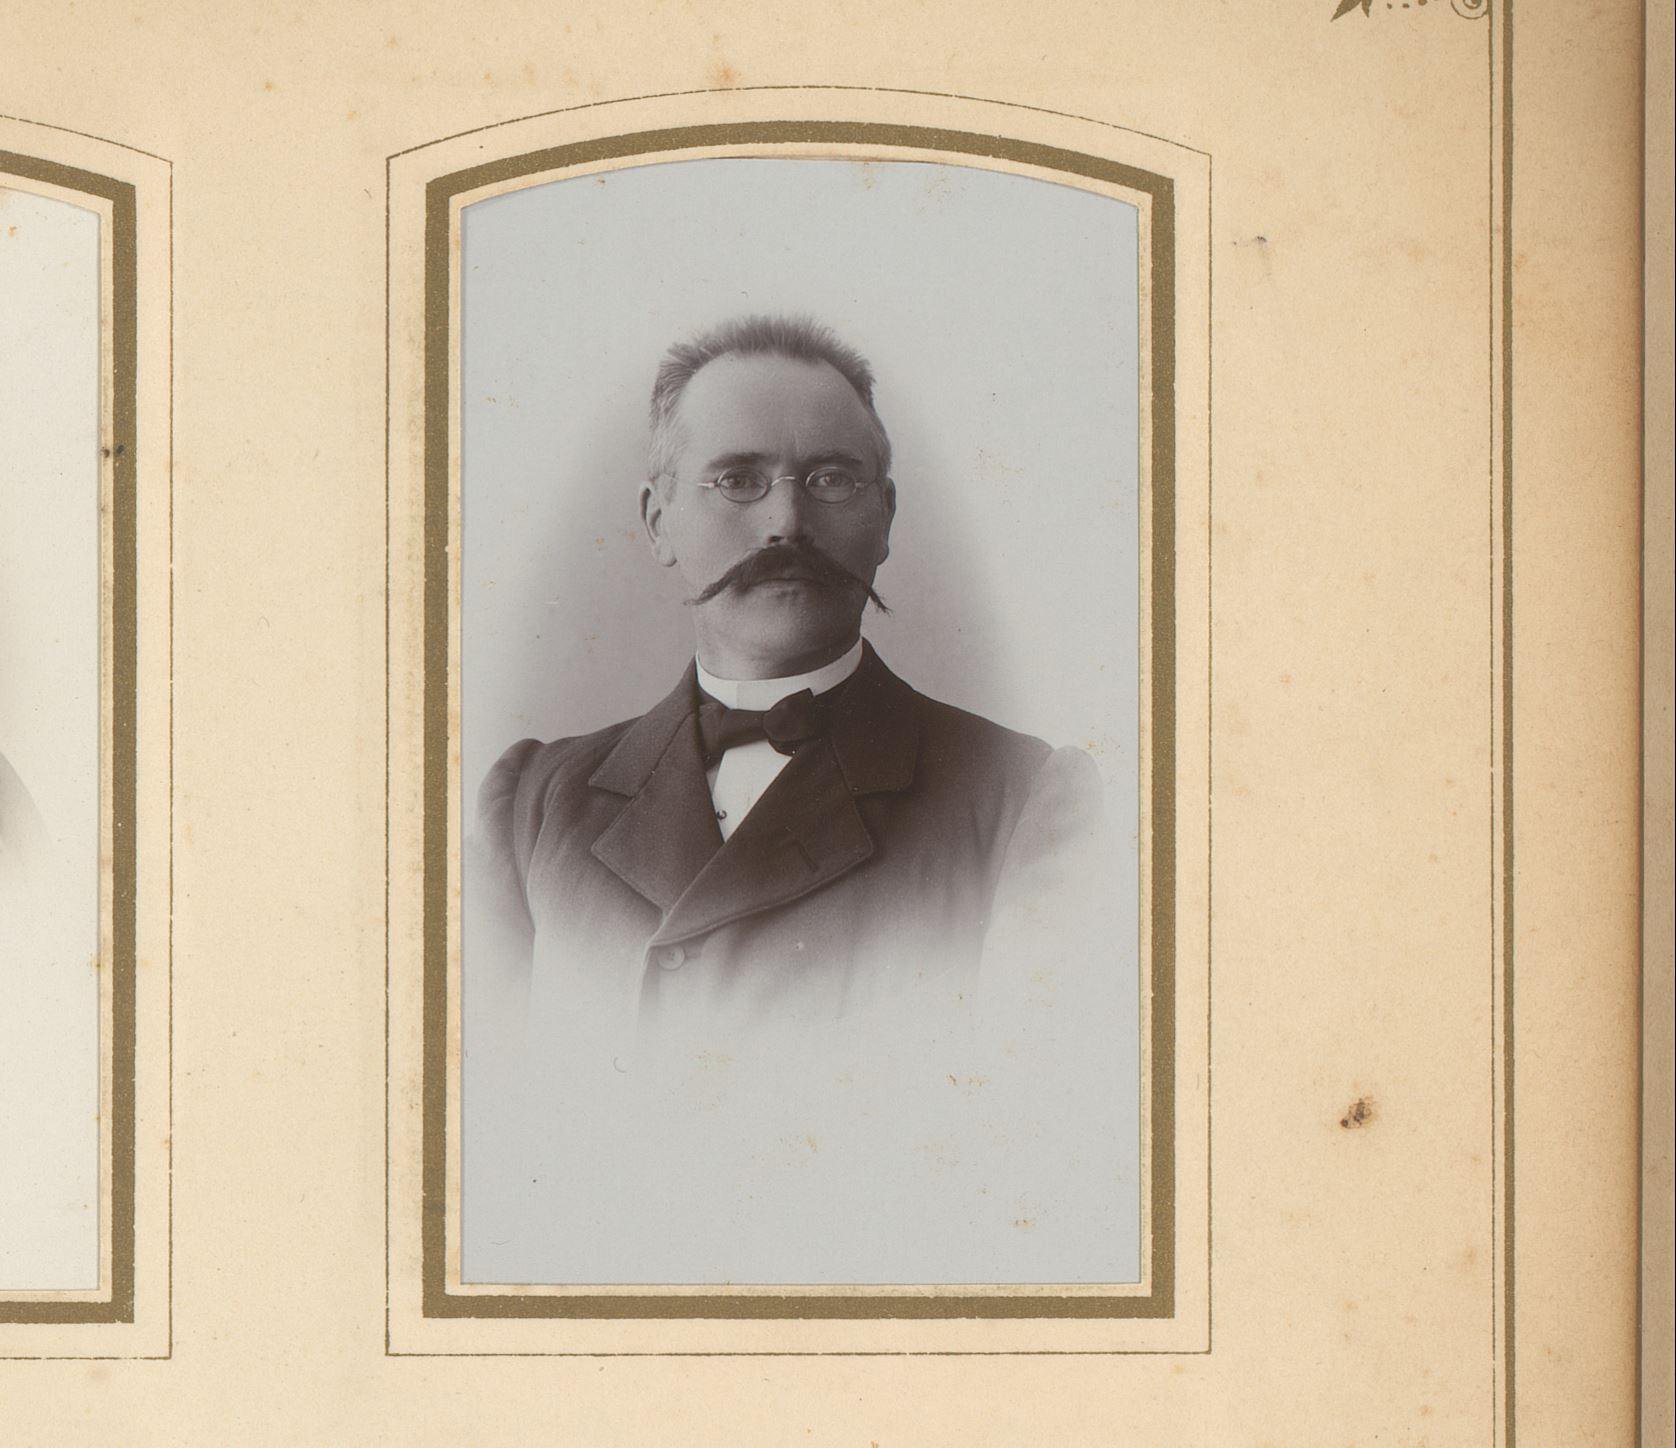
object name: album leaf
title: Portret van een man met snor en bril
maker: franciscus antonius gerardus blöte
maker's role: fotograaf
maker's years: 1873-1933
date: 1915-1923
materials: cardboard, photographic support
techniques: collodion silver print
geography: hoogezand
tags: eyeglasses, spectacles, moustache, historical persons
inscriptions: inscription: ‘F. A. G. BLÖTE,/ HOOGEZAND-SAPPEMEER/ tegenover 't STATION.’